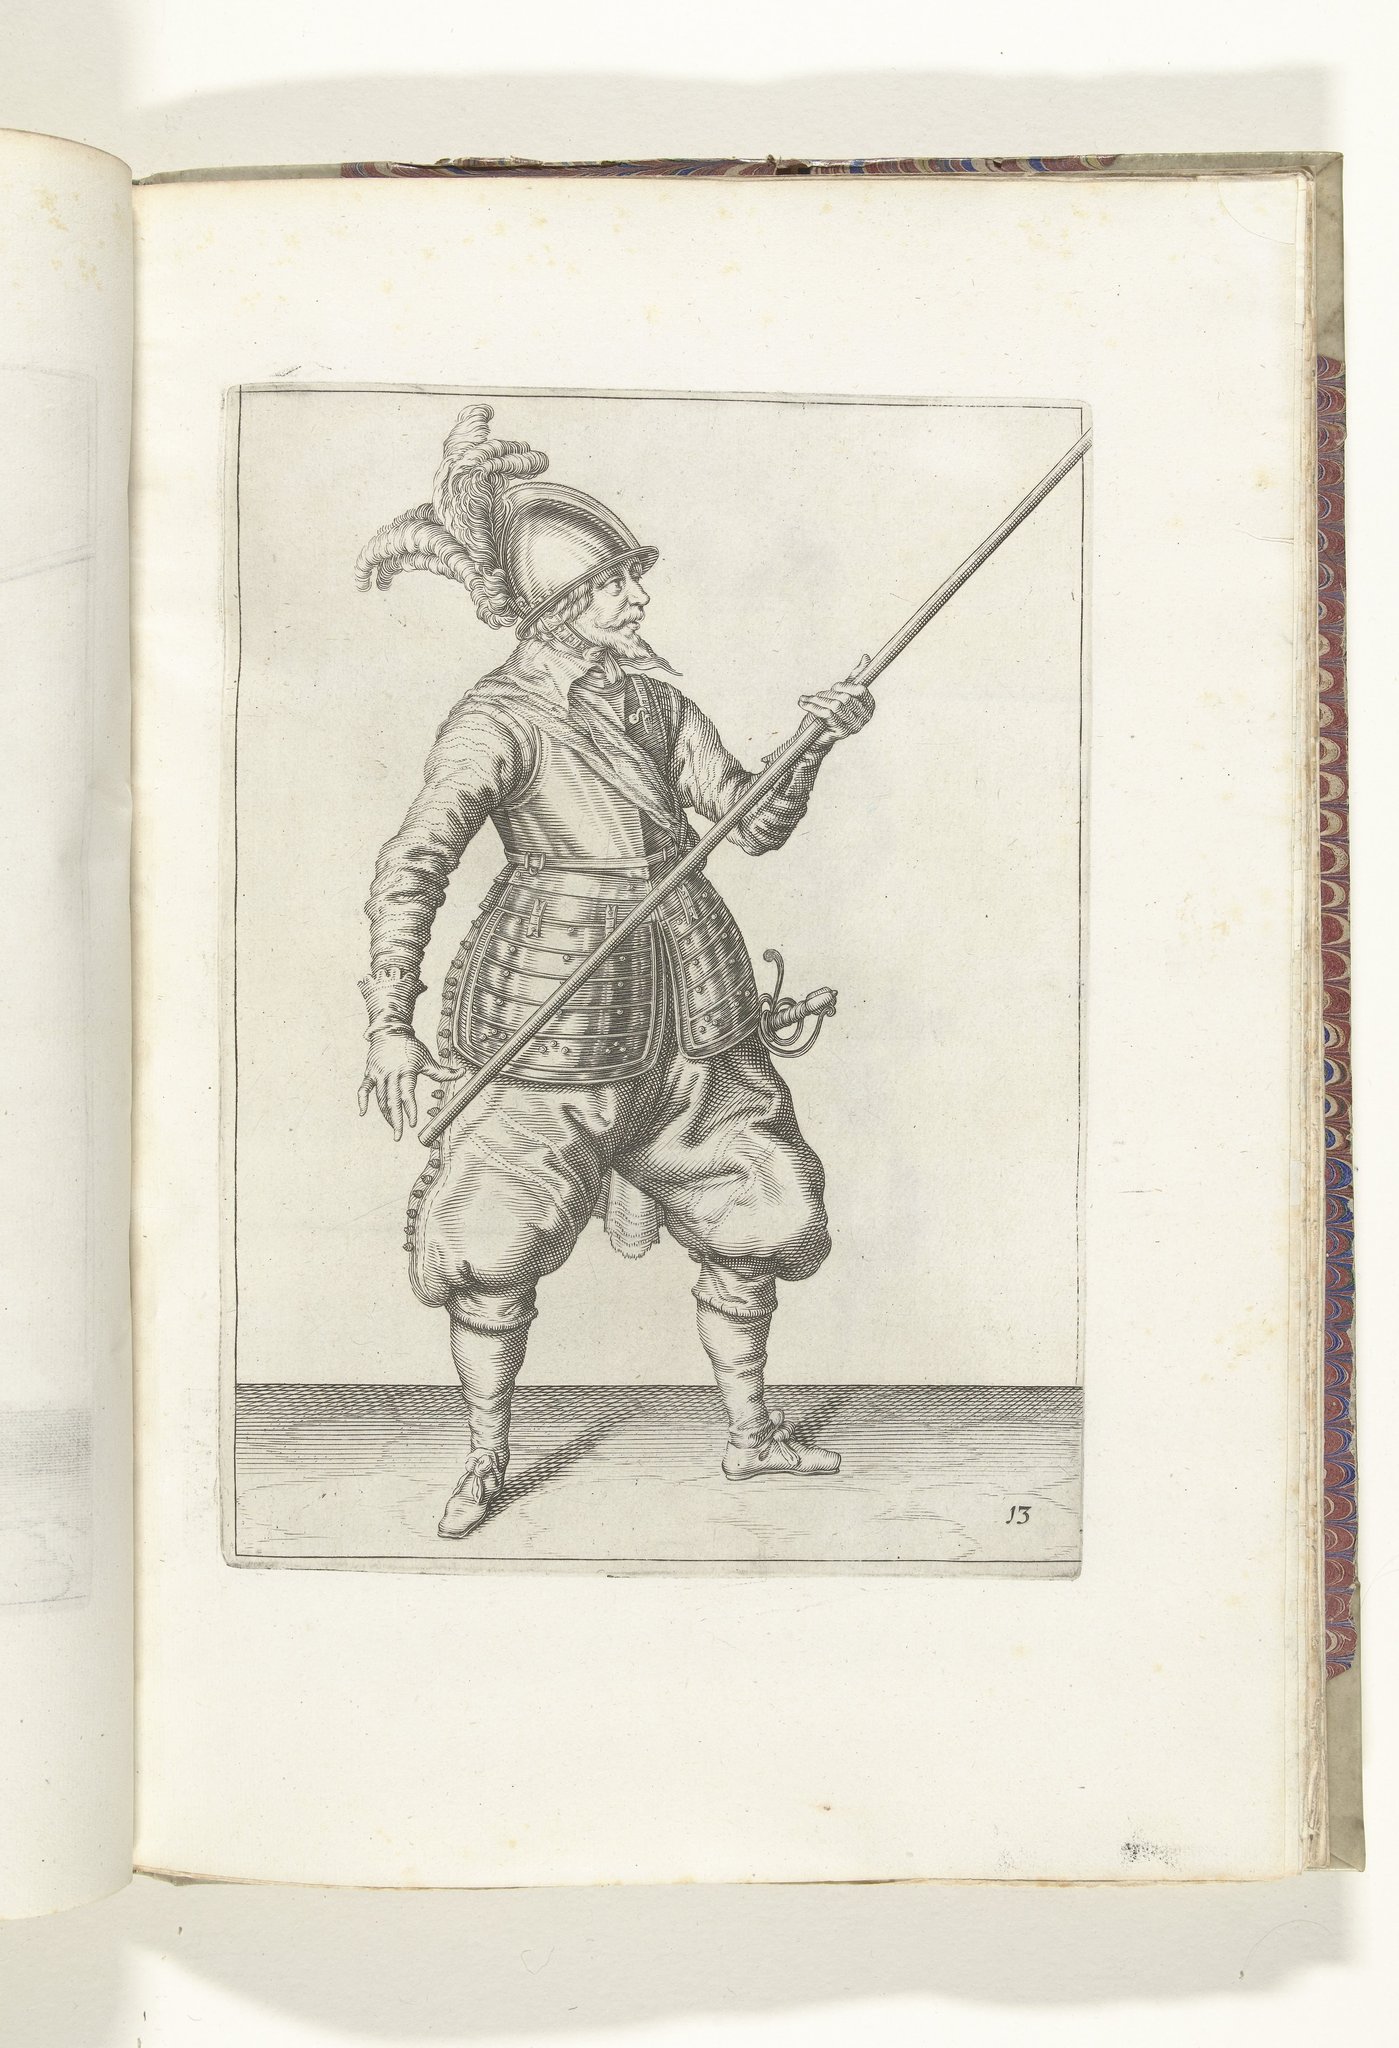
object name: print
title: Soldaat die zijn spies met zijn linkerhand bij zijn rechterzijde draagt, de punt schuin omhoog gericht (nr. 13), ca. 1600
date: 1597-1607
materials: paper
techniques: engraving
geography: amsterdam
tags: the hague, maurice (prince of orange), handling of weapons ~ military training, weapons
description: Een soldaat, ten voeten uit, die een spies (lans) met zijn linkerhand bij zijn rechterzijde draagt, de punt schuin omhoog gericht (nr. 13), ca. 1600. Dit is de tweede handeling voor het laten zakken van de spies om onder een overwelving door te kunnen. Plaat 13 in de instructies voor het hanteren van de spies: Corte onderwysinghe op de figuerliicke afbeeldinghe belanghende trechte gebruck, van alle t'ghene een Soldaet int handelen vande Spies noodich is. Onderdeel van de illustraties in: J. de Gheyn, Wapenhandelinghe van Roers Musquetten ende spiessen, Amsterdam, 1608. Krijgswezen rond 1600.